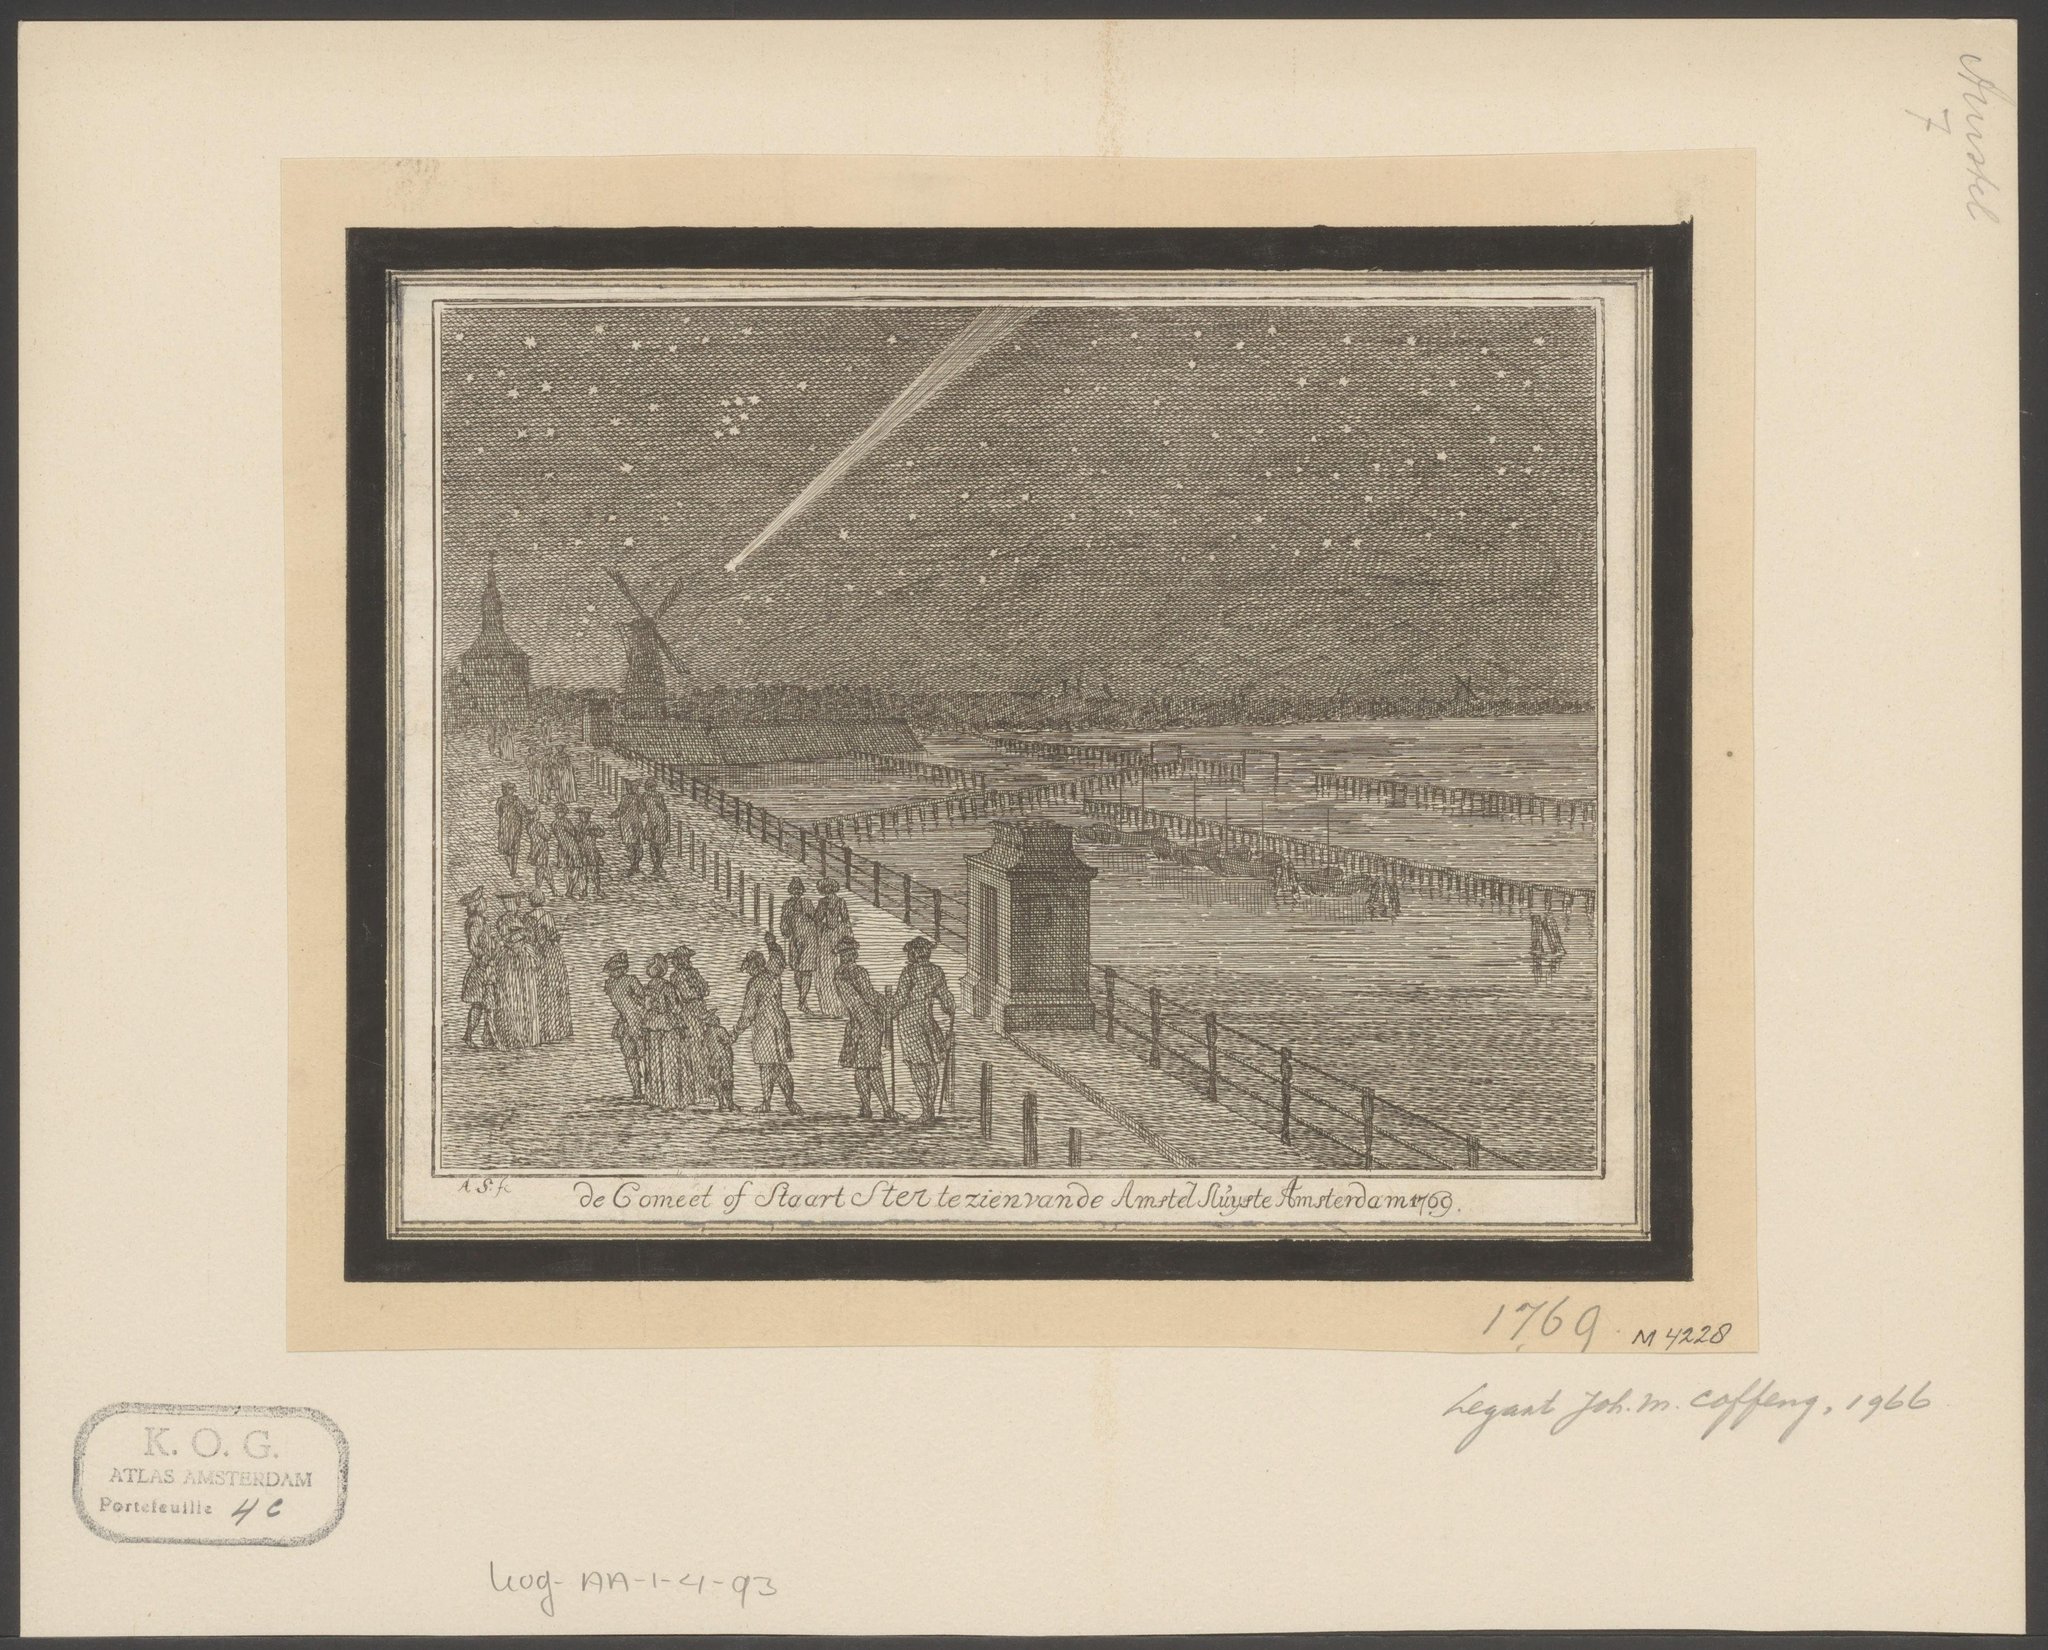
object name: print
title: Komeet gezien vanaf de Hogesluis te Amsterdam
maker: aert schouman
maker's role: draughtsman, painter, print maker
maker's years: 1710-1792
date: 1769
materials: ink, paper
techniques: brush, etching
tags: city-view in general; 'veduta', river, comet, windmill in landscape, bridge in city across river, canal, etc.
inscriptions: inscription: ‘Legaat Joh. M. Coffeng. 1966’, collector's mark: ‘4C’ Lugt 1641b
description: Onderwerpsrubriek binnen de Atlas Amsterdam: Amstel van Hogesluis stroomopwaarts.